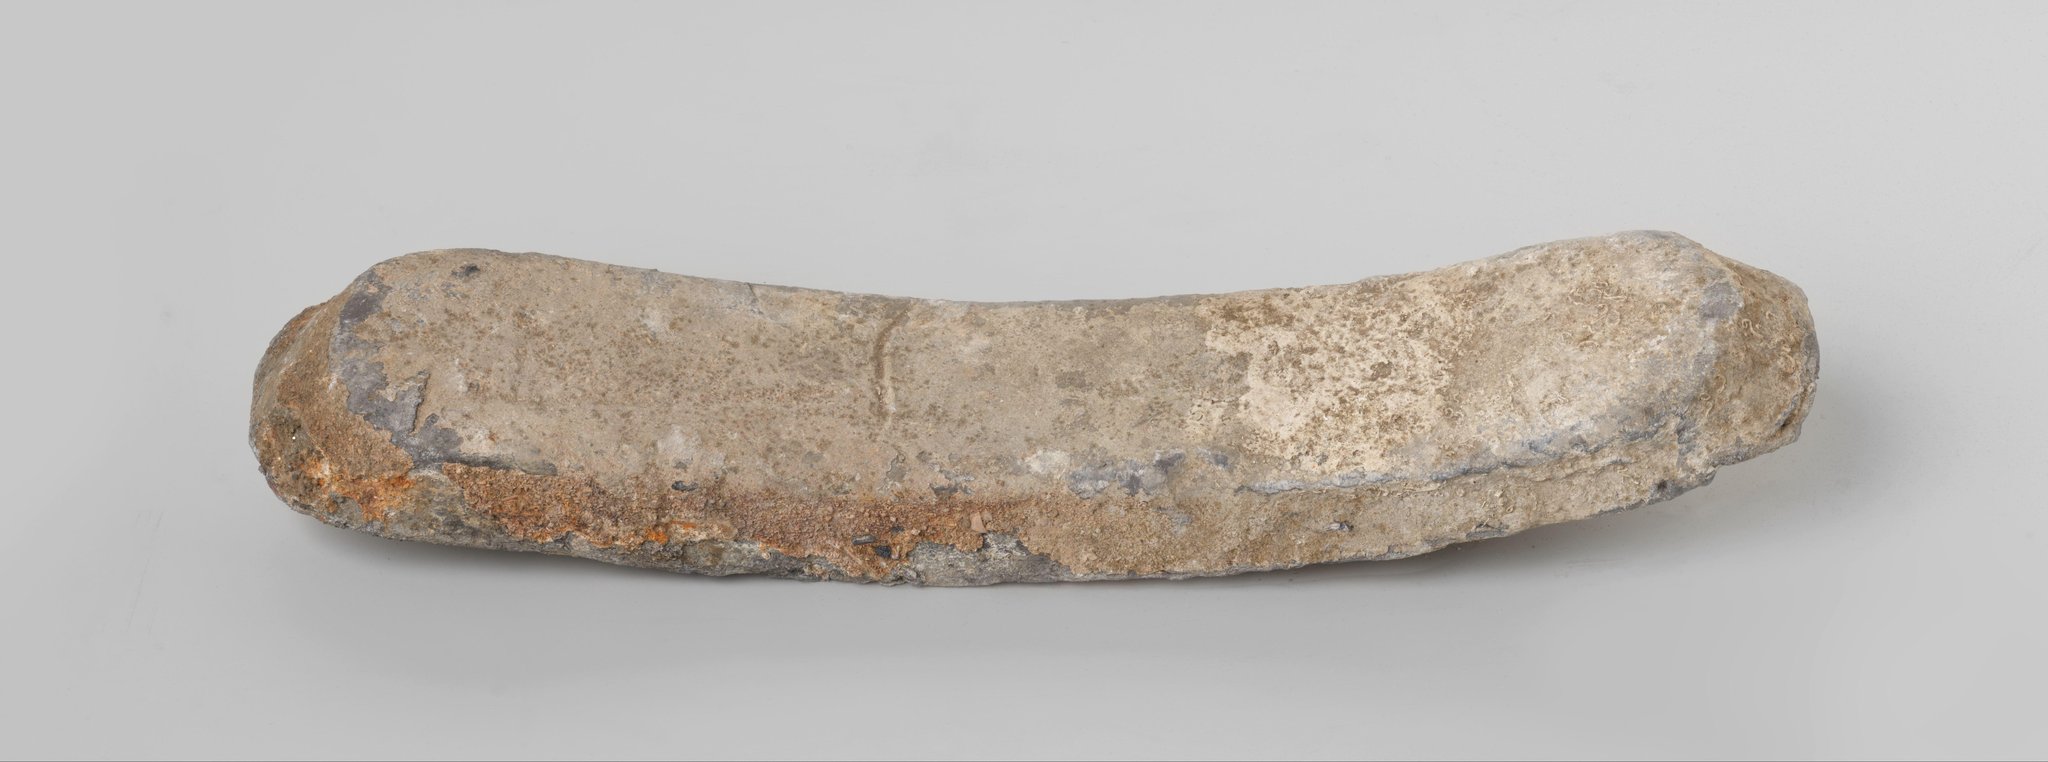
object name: ingot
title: Ballastlood uit het wrak van de Oost-Indiëvaarder Hollandia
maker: Anonymous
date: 1700-1743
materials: lead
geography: netherlands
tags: verenigde oostindische compagnie, hollandia (schip), annet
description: Ingot; (1) sim. 70-267H, bent (80l, 16w, 6.8h, underside 14w), corroded, no marks visible.